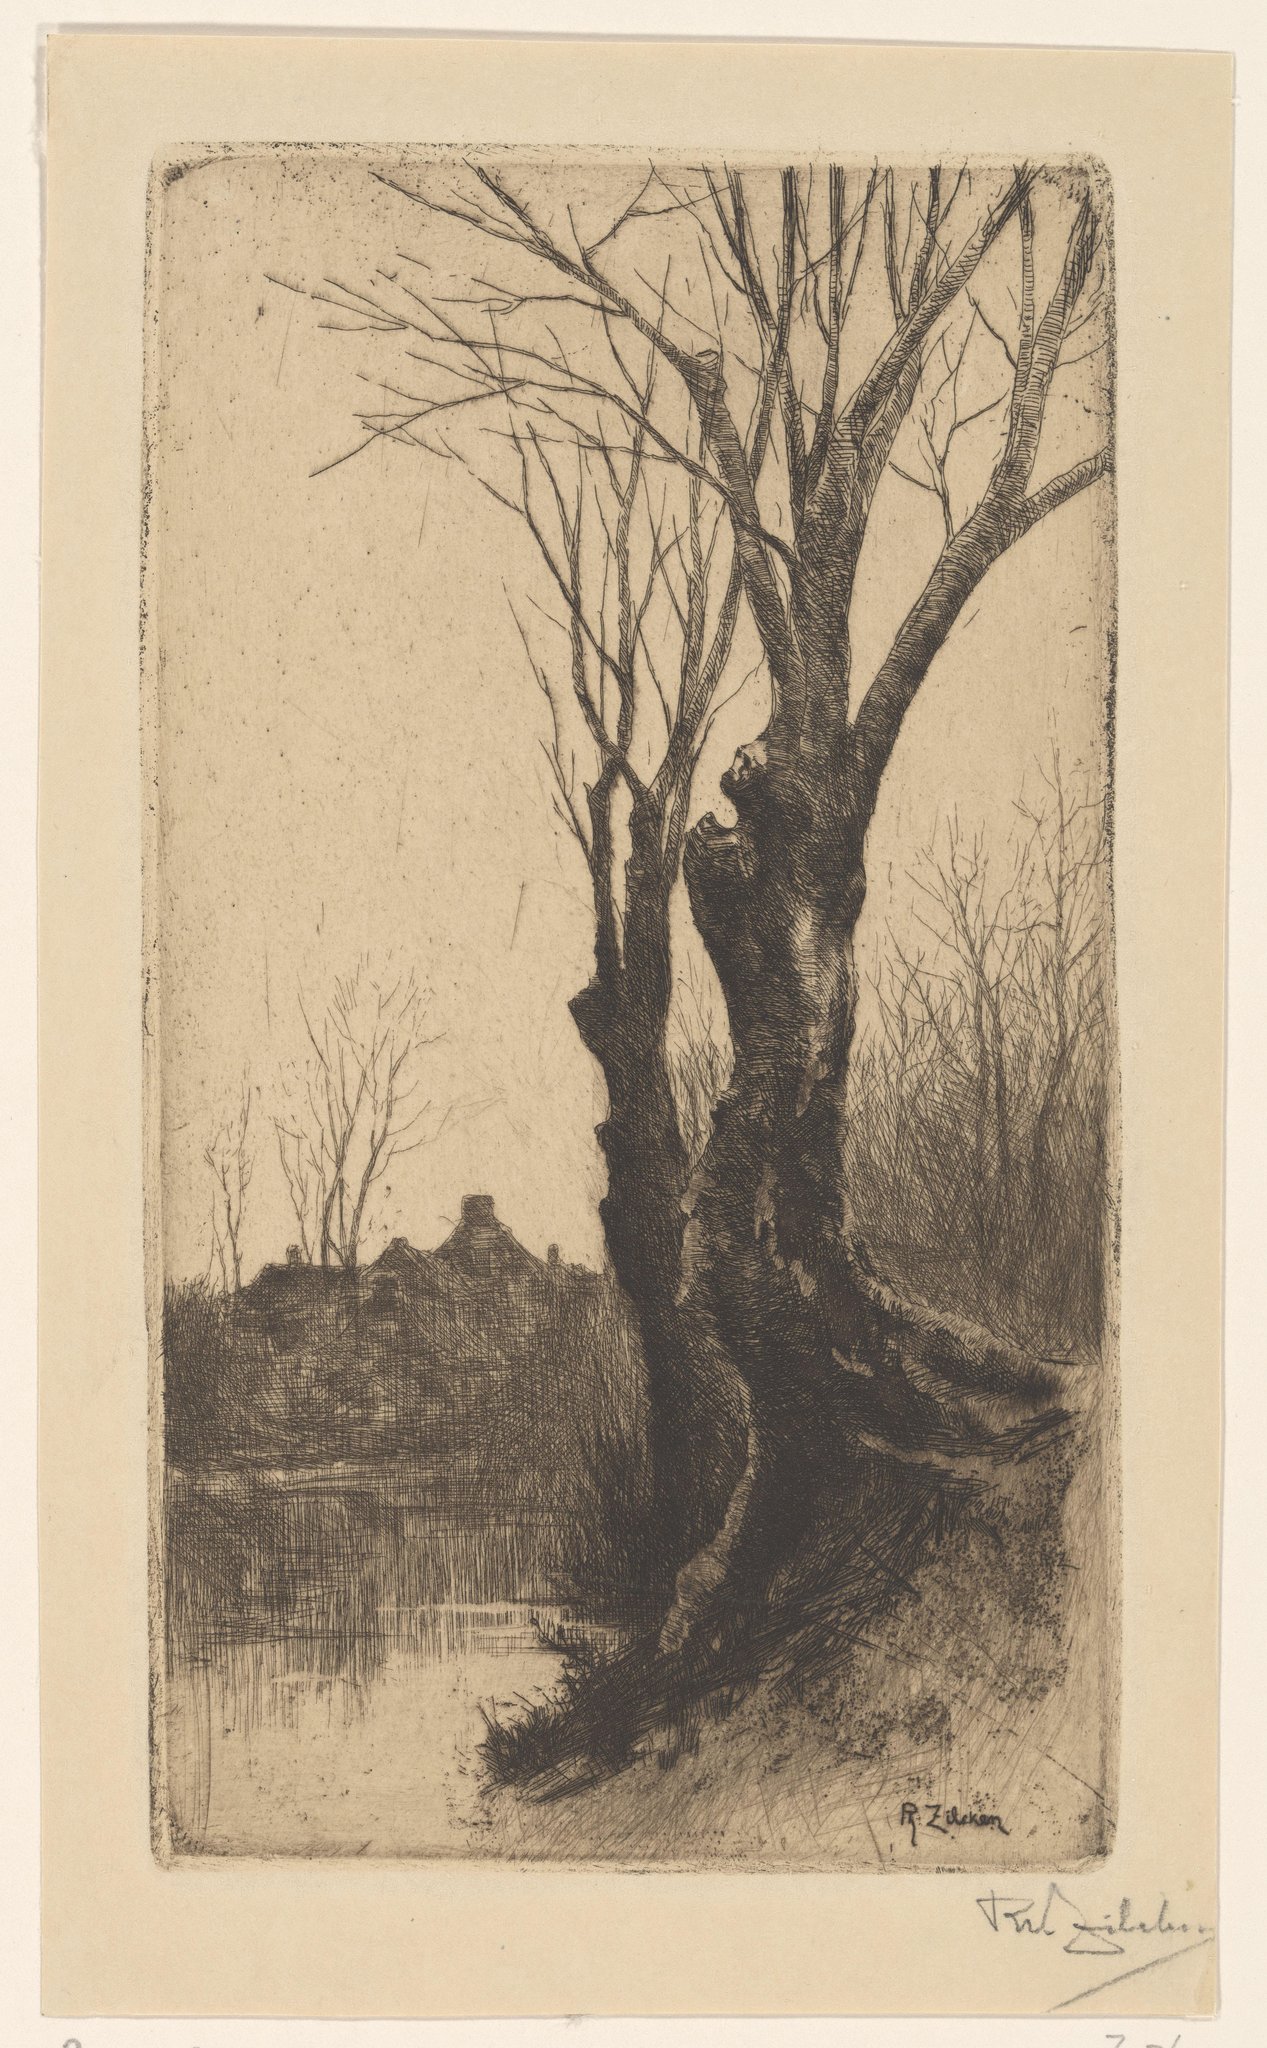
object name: print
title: Gezicht op de Loolaan, bij Den Haag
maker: philip zilcken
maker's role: draughtsman, painter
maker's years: 1857-1930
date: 1886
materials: paper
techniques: drypoint, etching, intaglio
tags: trees, the hague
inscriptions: collector's mark: Lugt 2228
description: Prent verscheen in 1886 als onderdeel van de jaarlijkse uitgave van de 'Portefeuille der Nederlandsche Etsclub'.